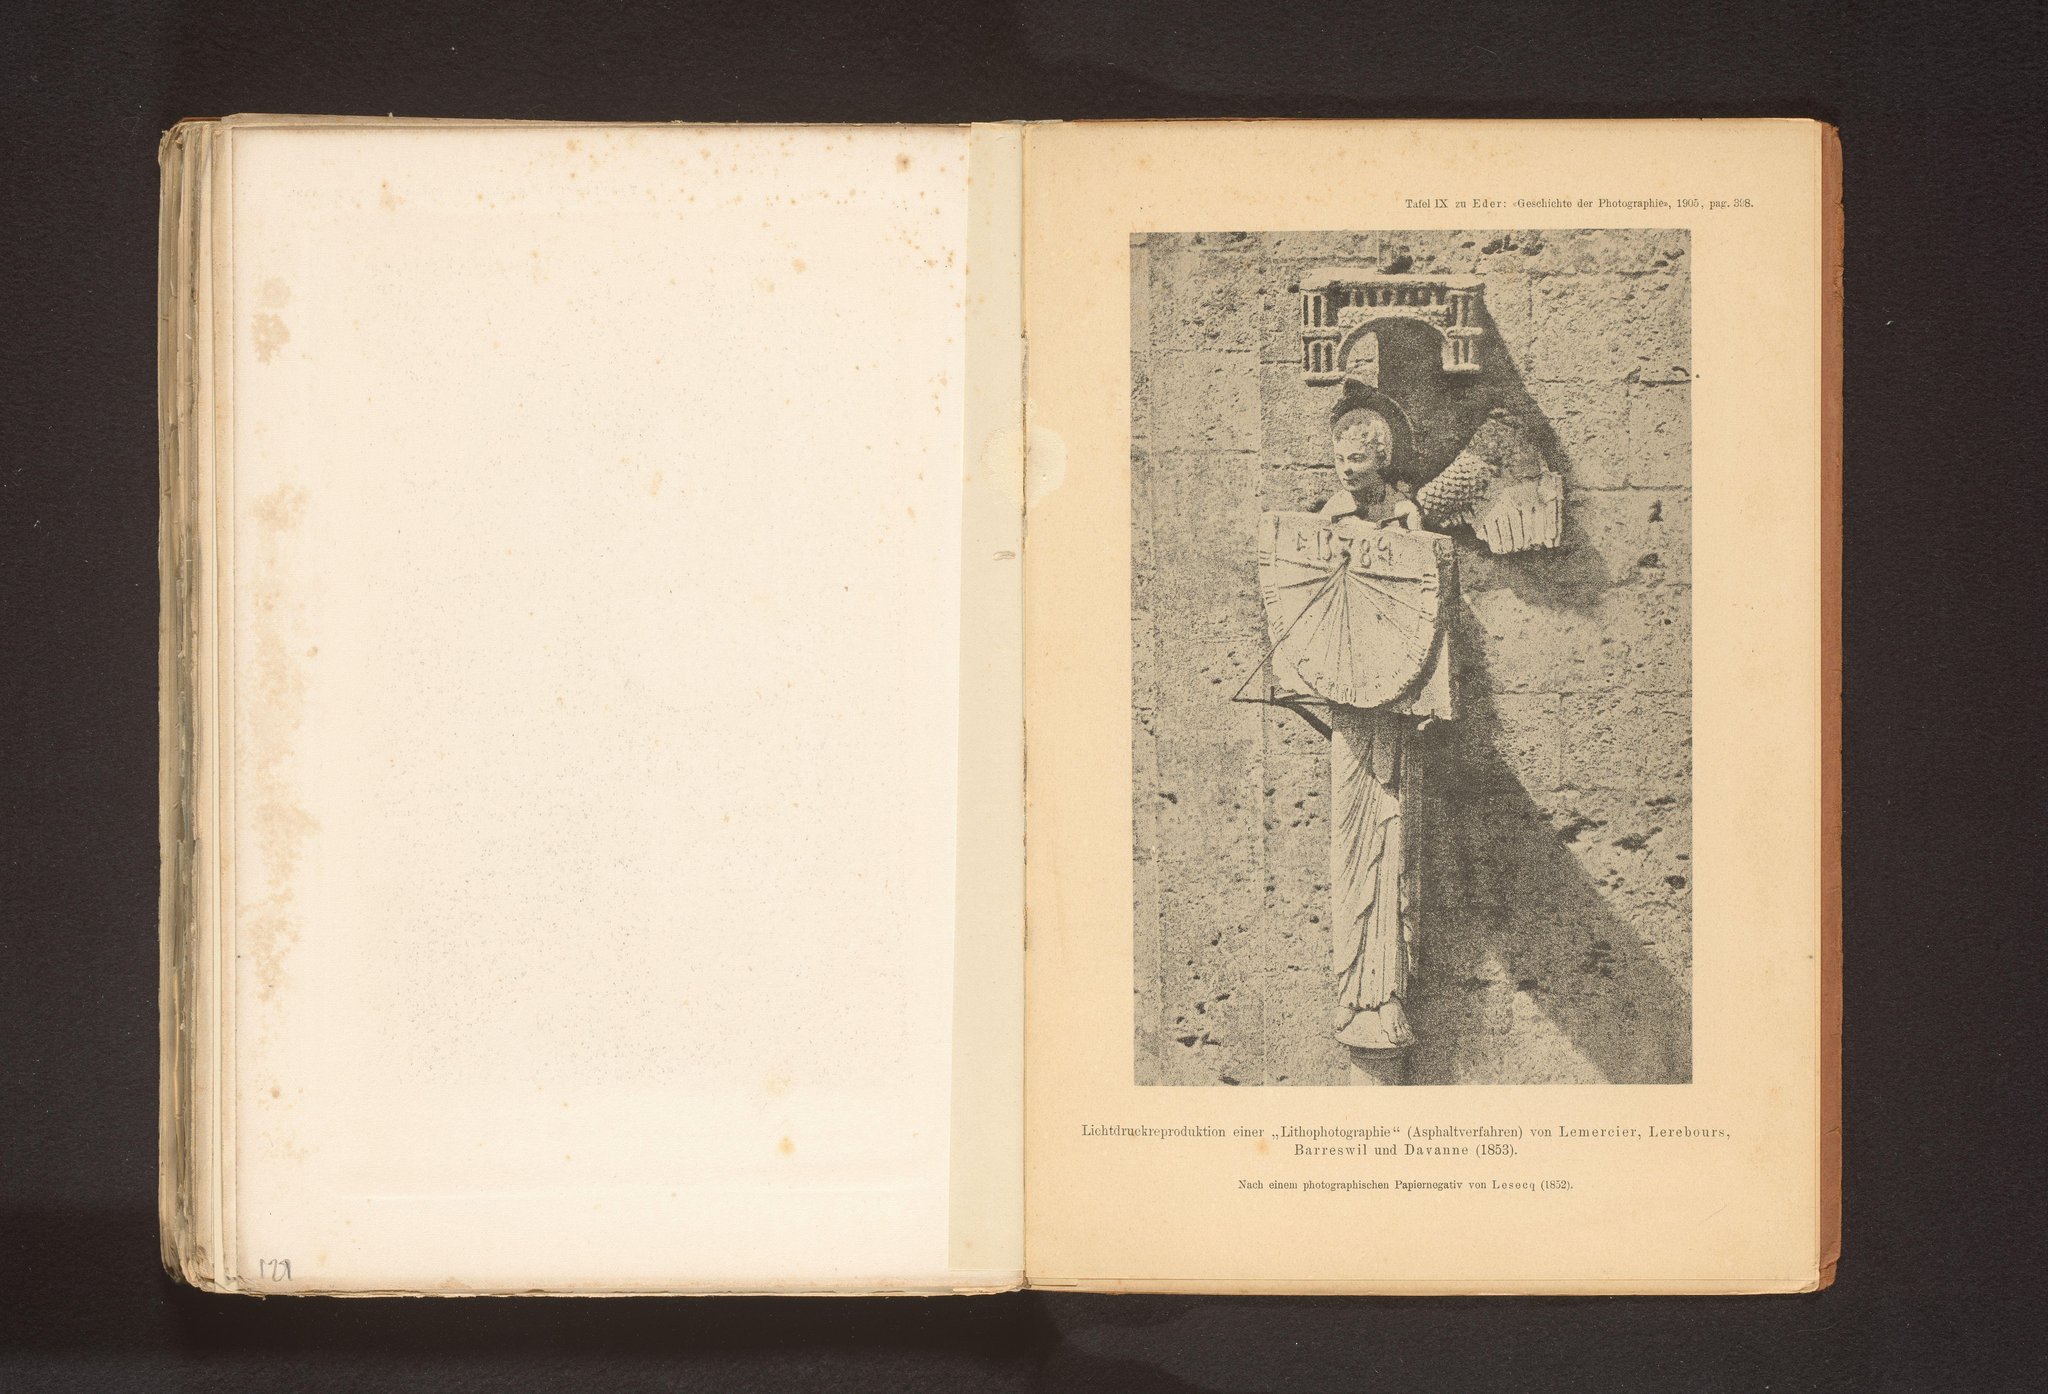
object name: page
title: Sculptuur van een engel met een zonnewijzer aan de gevel van de Kathedraal van Chartres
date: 1900-1905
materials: paper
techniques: photograph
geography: chartres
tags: church (exterior), sculpture, sundial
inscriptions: number: ‘Tafel IX’, inscription: ‘Lichtdruckreproduktion (...) Davanne (1853)’